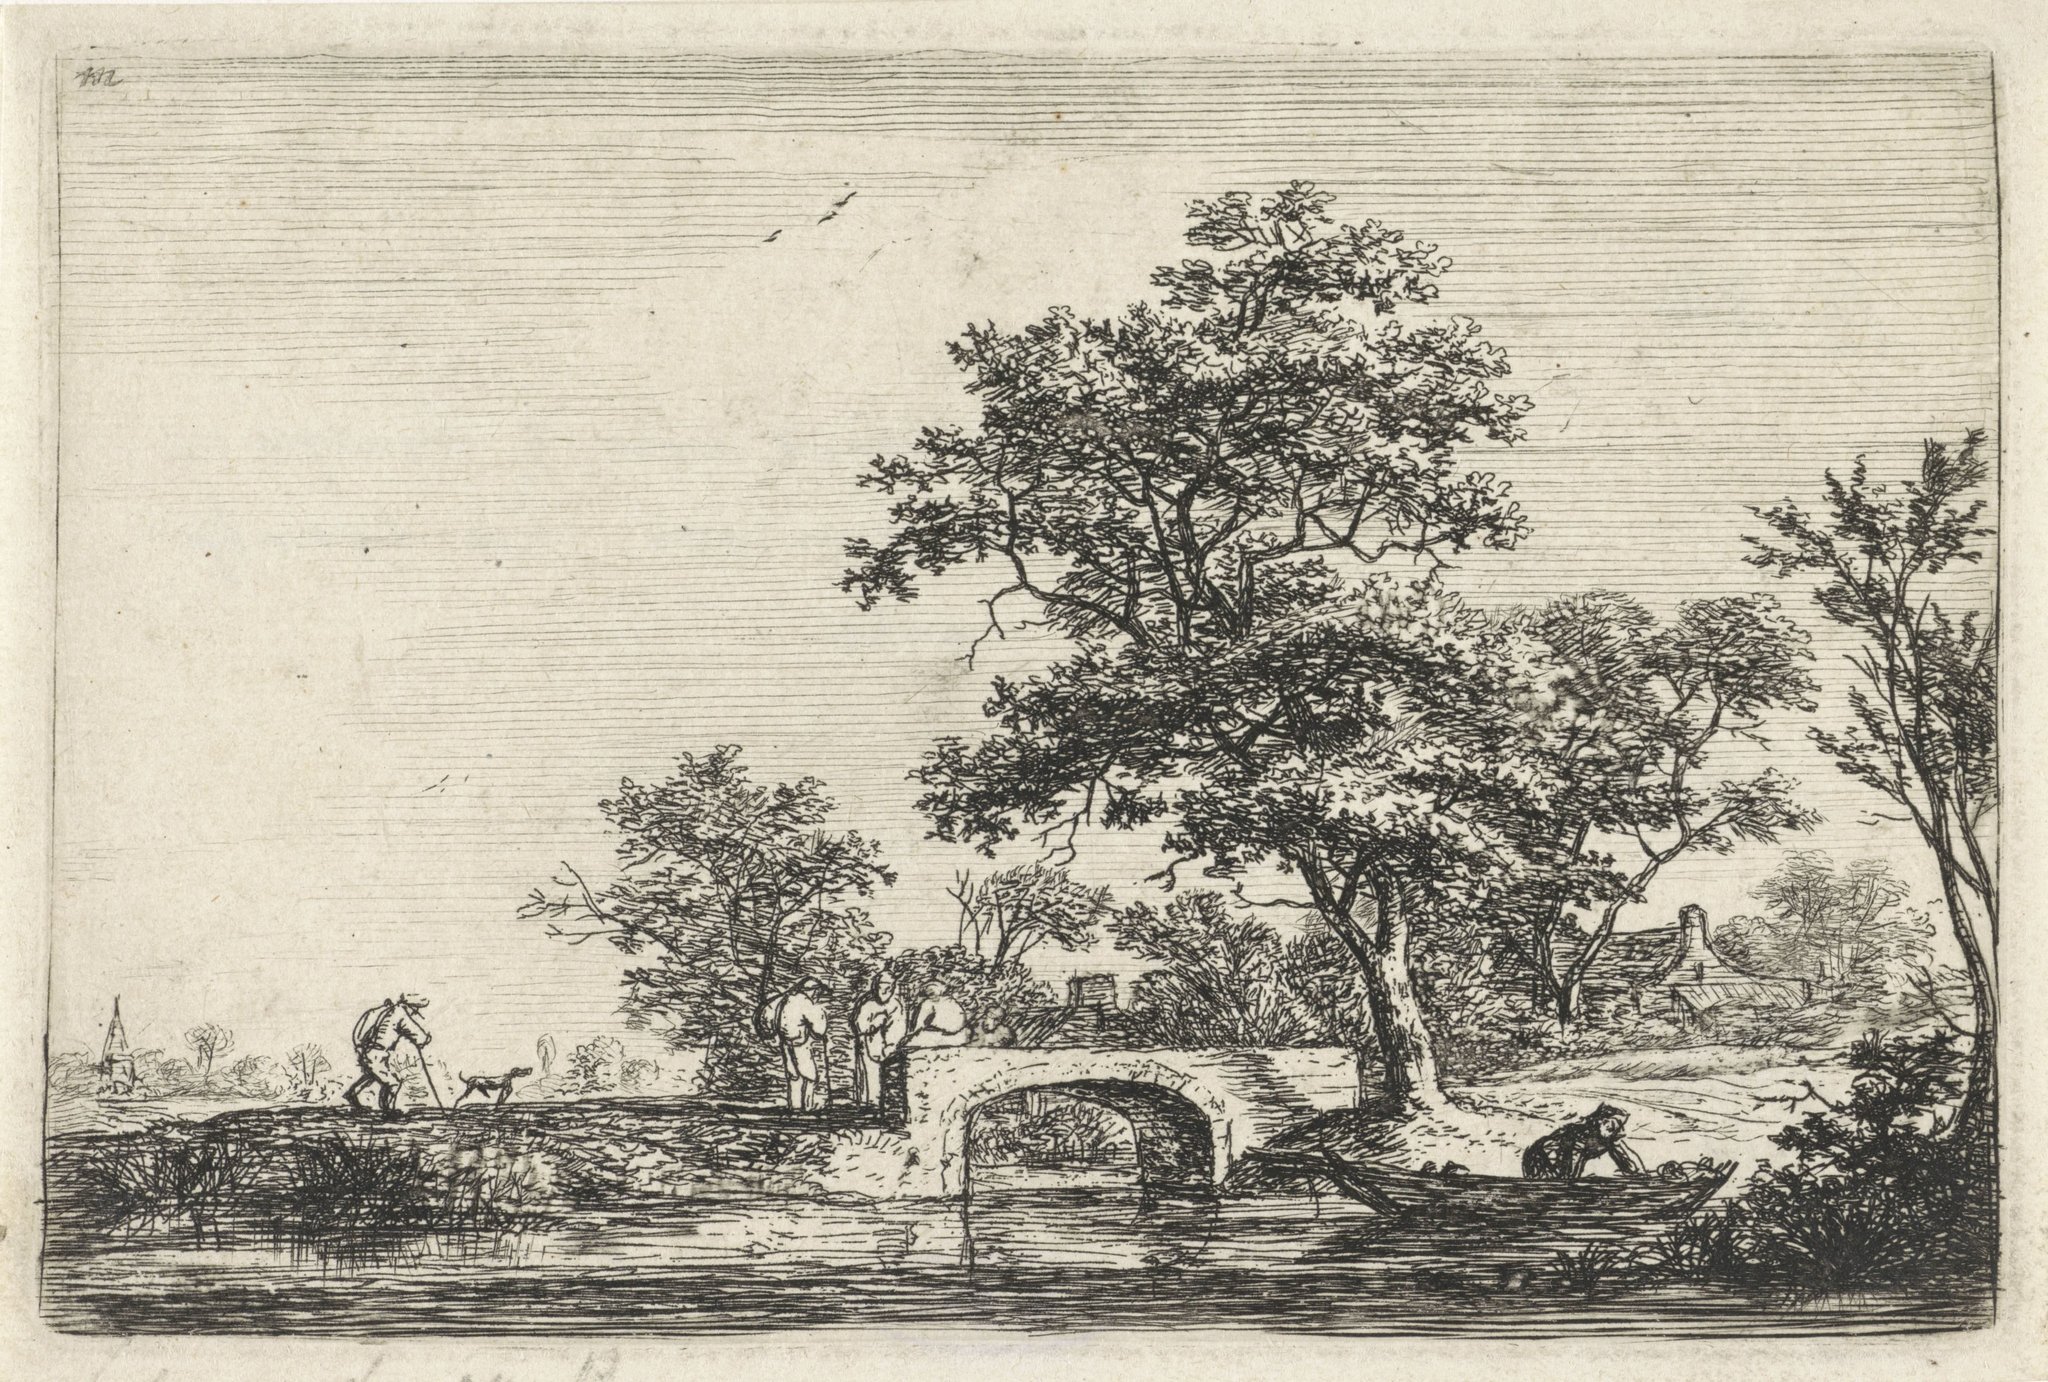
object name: print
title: Figuren bij een stenen brug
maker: anthonie waterloo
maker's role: draughtsman, painter, print maker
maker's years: 1609-1690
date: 1630-1663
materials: paper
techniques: etching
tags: landscape with bridge, viaduct or aqueduct, landscapes with waters, waterscapes, seascapes (in the temperate zone), village, rowing-boat, canoe, etc., 'en route', traveller under way, landscapes (+ landscape with figures, staffage)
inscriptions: collector's mark: Lugt 1209, collector's mark: Lugt 2228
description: Een stenen brug over het water leidt naar een dorp. Bij de brug zijn drie figuren afgebeeld en links komt een vierde persoon met een hond aangelopen. Rechtsvoor is een man in een roeiboot weergegeven. Linksboven is de letter m te zien.